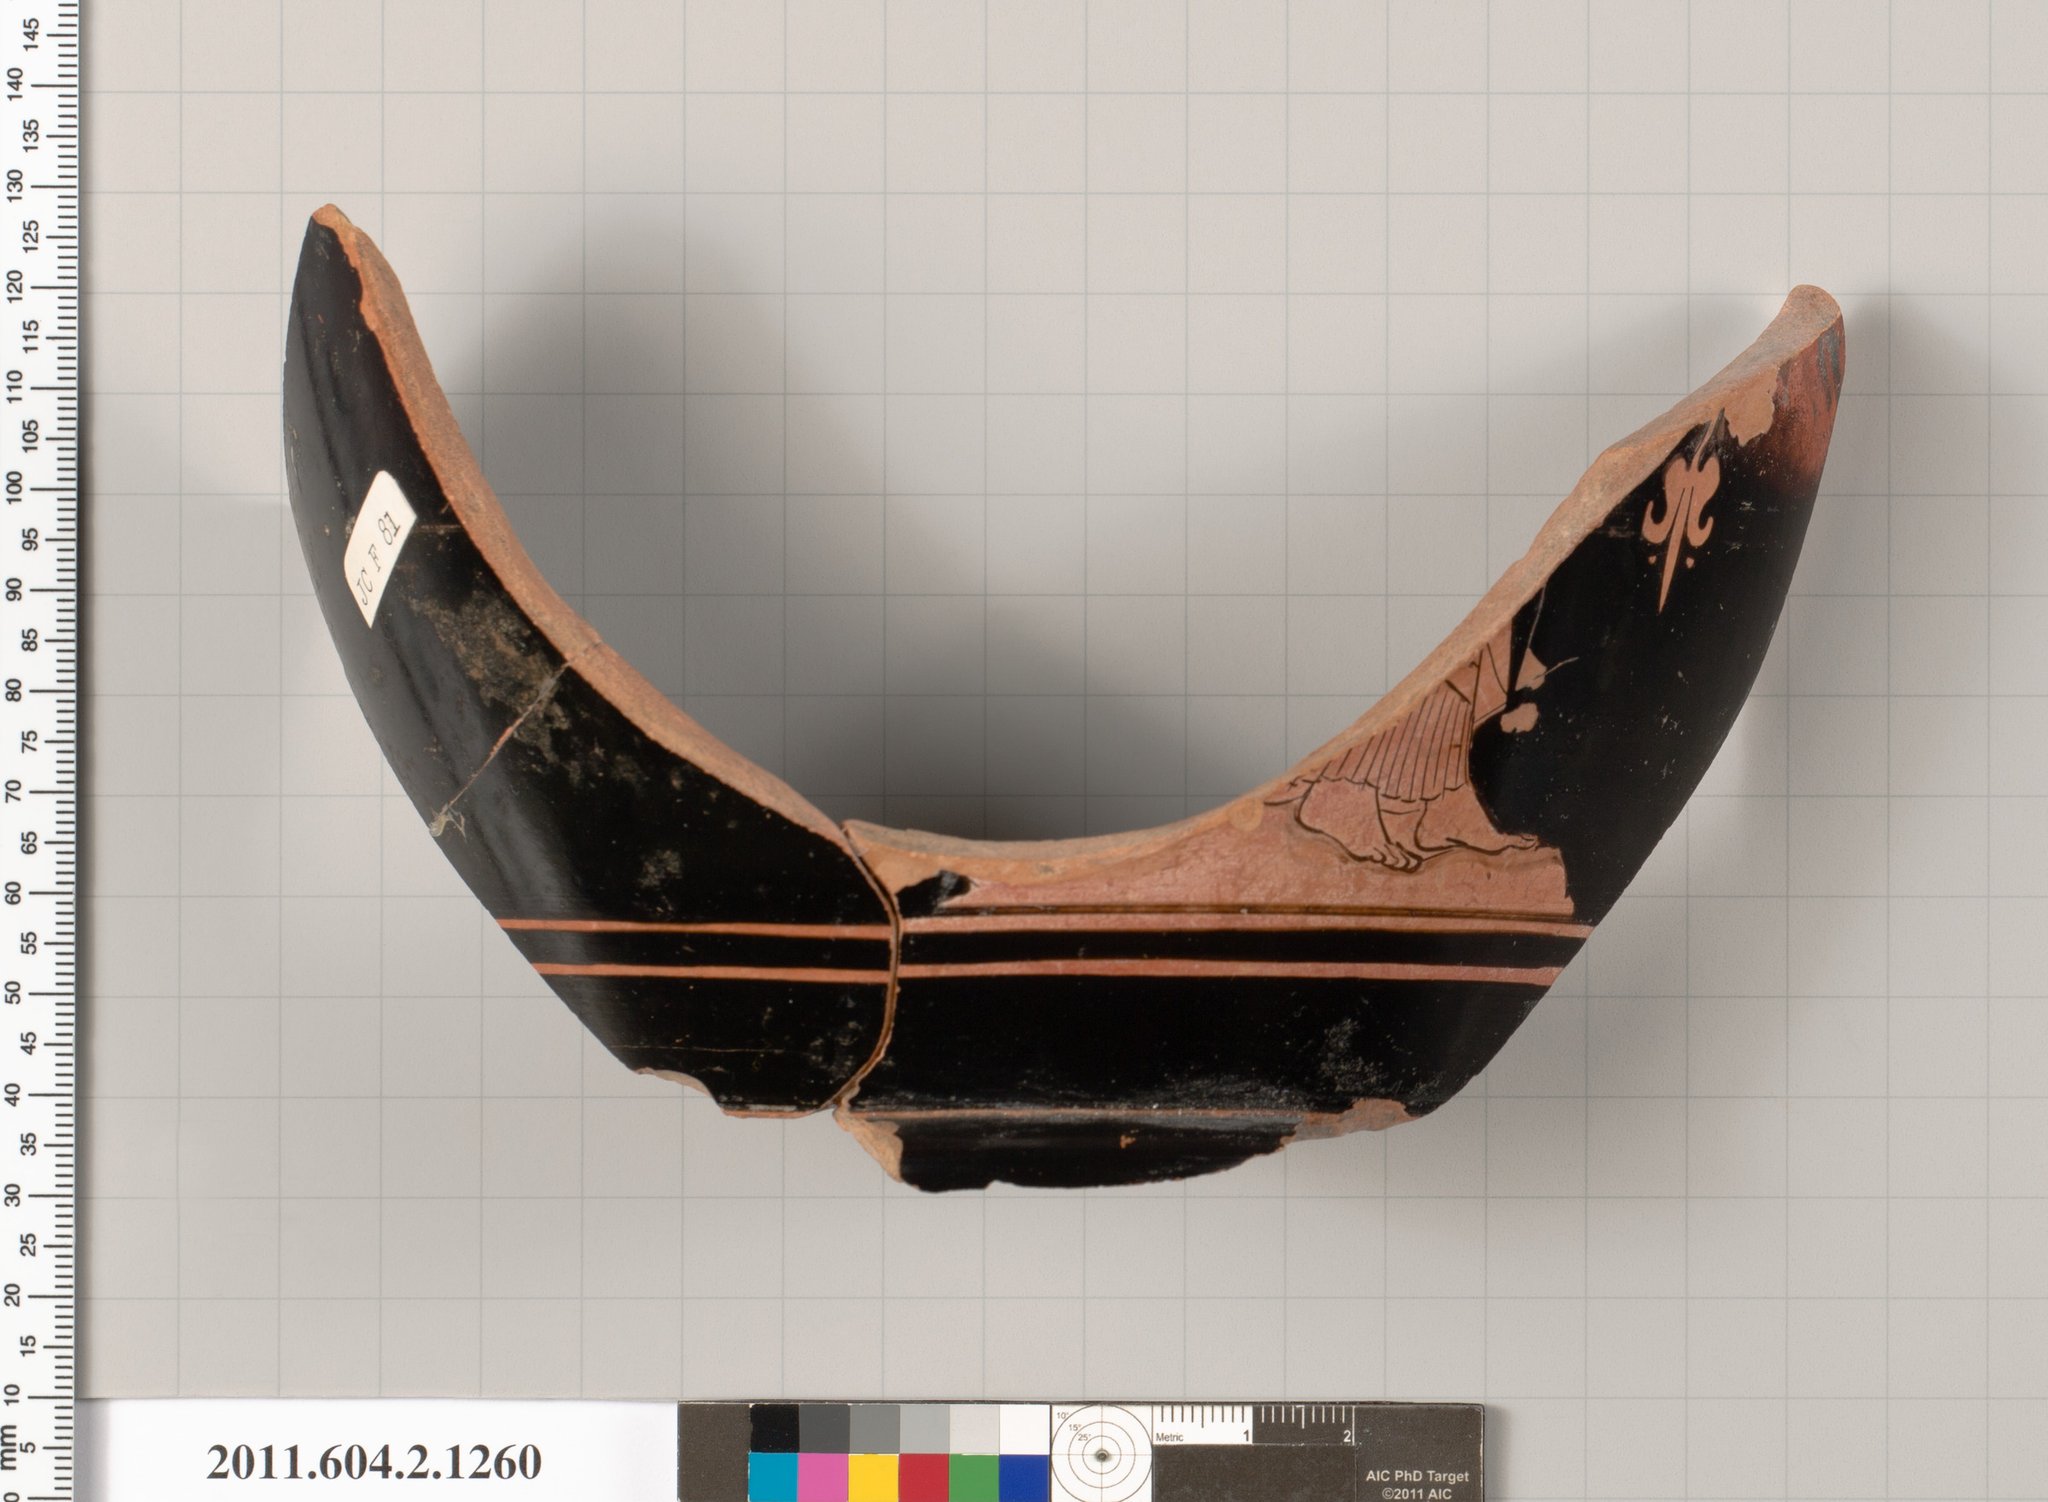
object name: skyphos fragment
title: Terracotta fragment of a skyphos (deep drinking cup)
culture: greek, attic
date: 490-480 BCE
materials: terracotta